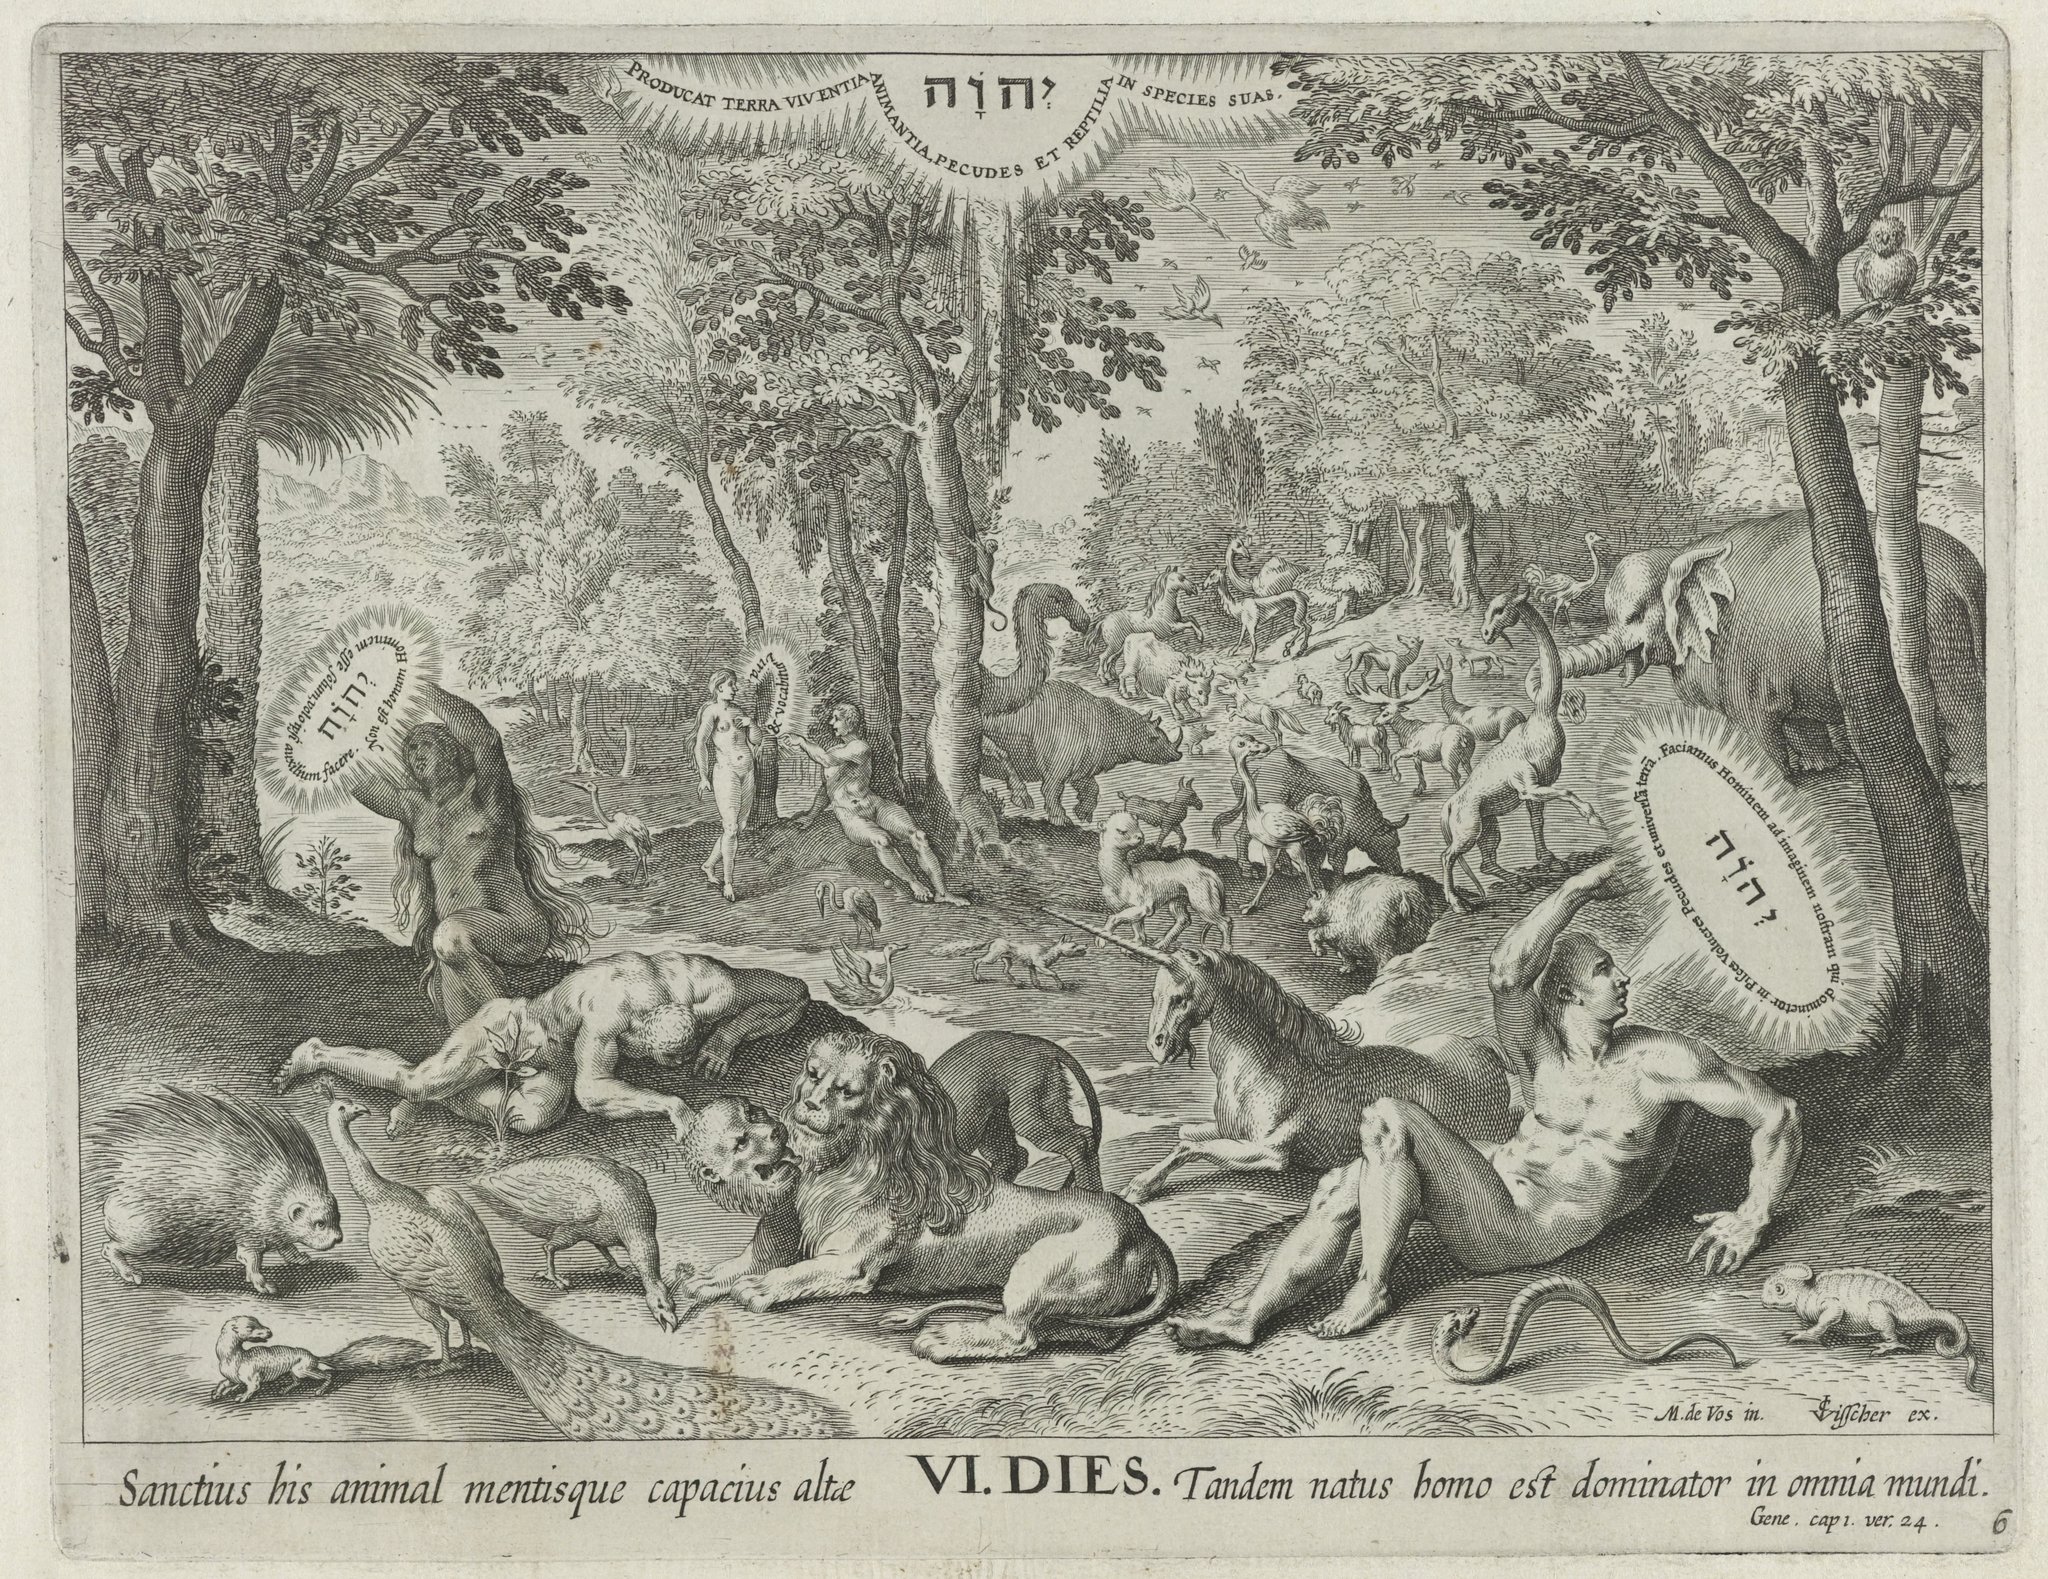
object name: print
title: Zesde scheppingsdag: schepping van Adam en Eva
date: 1639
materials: paper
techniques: engraving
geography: amsterdam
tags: creation of man; the garden of eden (genesis 1:26 - 2), unicorn, animals, creation of eve, tetragram (in roman or hebrew script) ~ symbol of god the father, beasts of prey, predatory animals: lion, creation of land-animals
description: Te midden van de dieren worden Adam en Eva geschapen door God de Vader in de vorm van een tetragram. Rechts op de voorgrond buigt God zich over Adam; links wordt Eva uit de rib van Adam geschapen. In het midden twee leeuwen, een eenhoorn en andere dieren. In het midden op de achtergrond geeft God Eva aan Adam. Op de zesde dag van de schepping schiep God Adam en Eva. Onder de voorstelling een verwijzing in het Latijn naar de Bijbeltekst in Gen. 1:24. Deze prent maakt deel uit van een album.